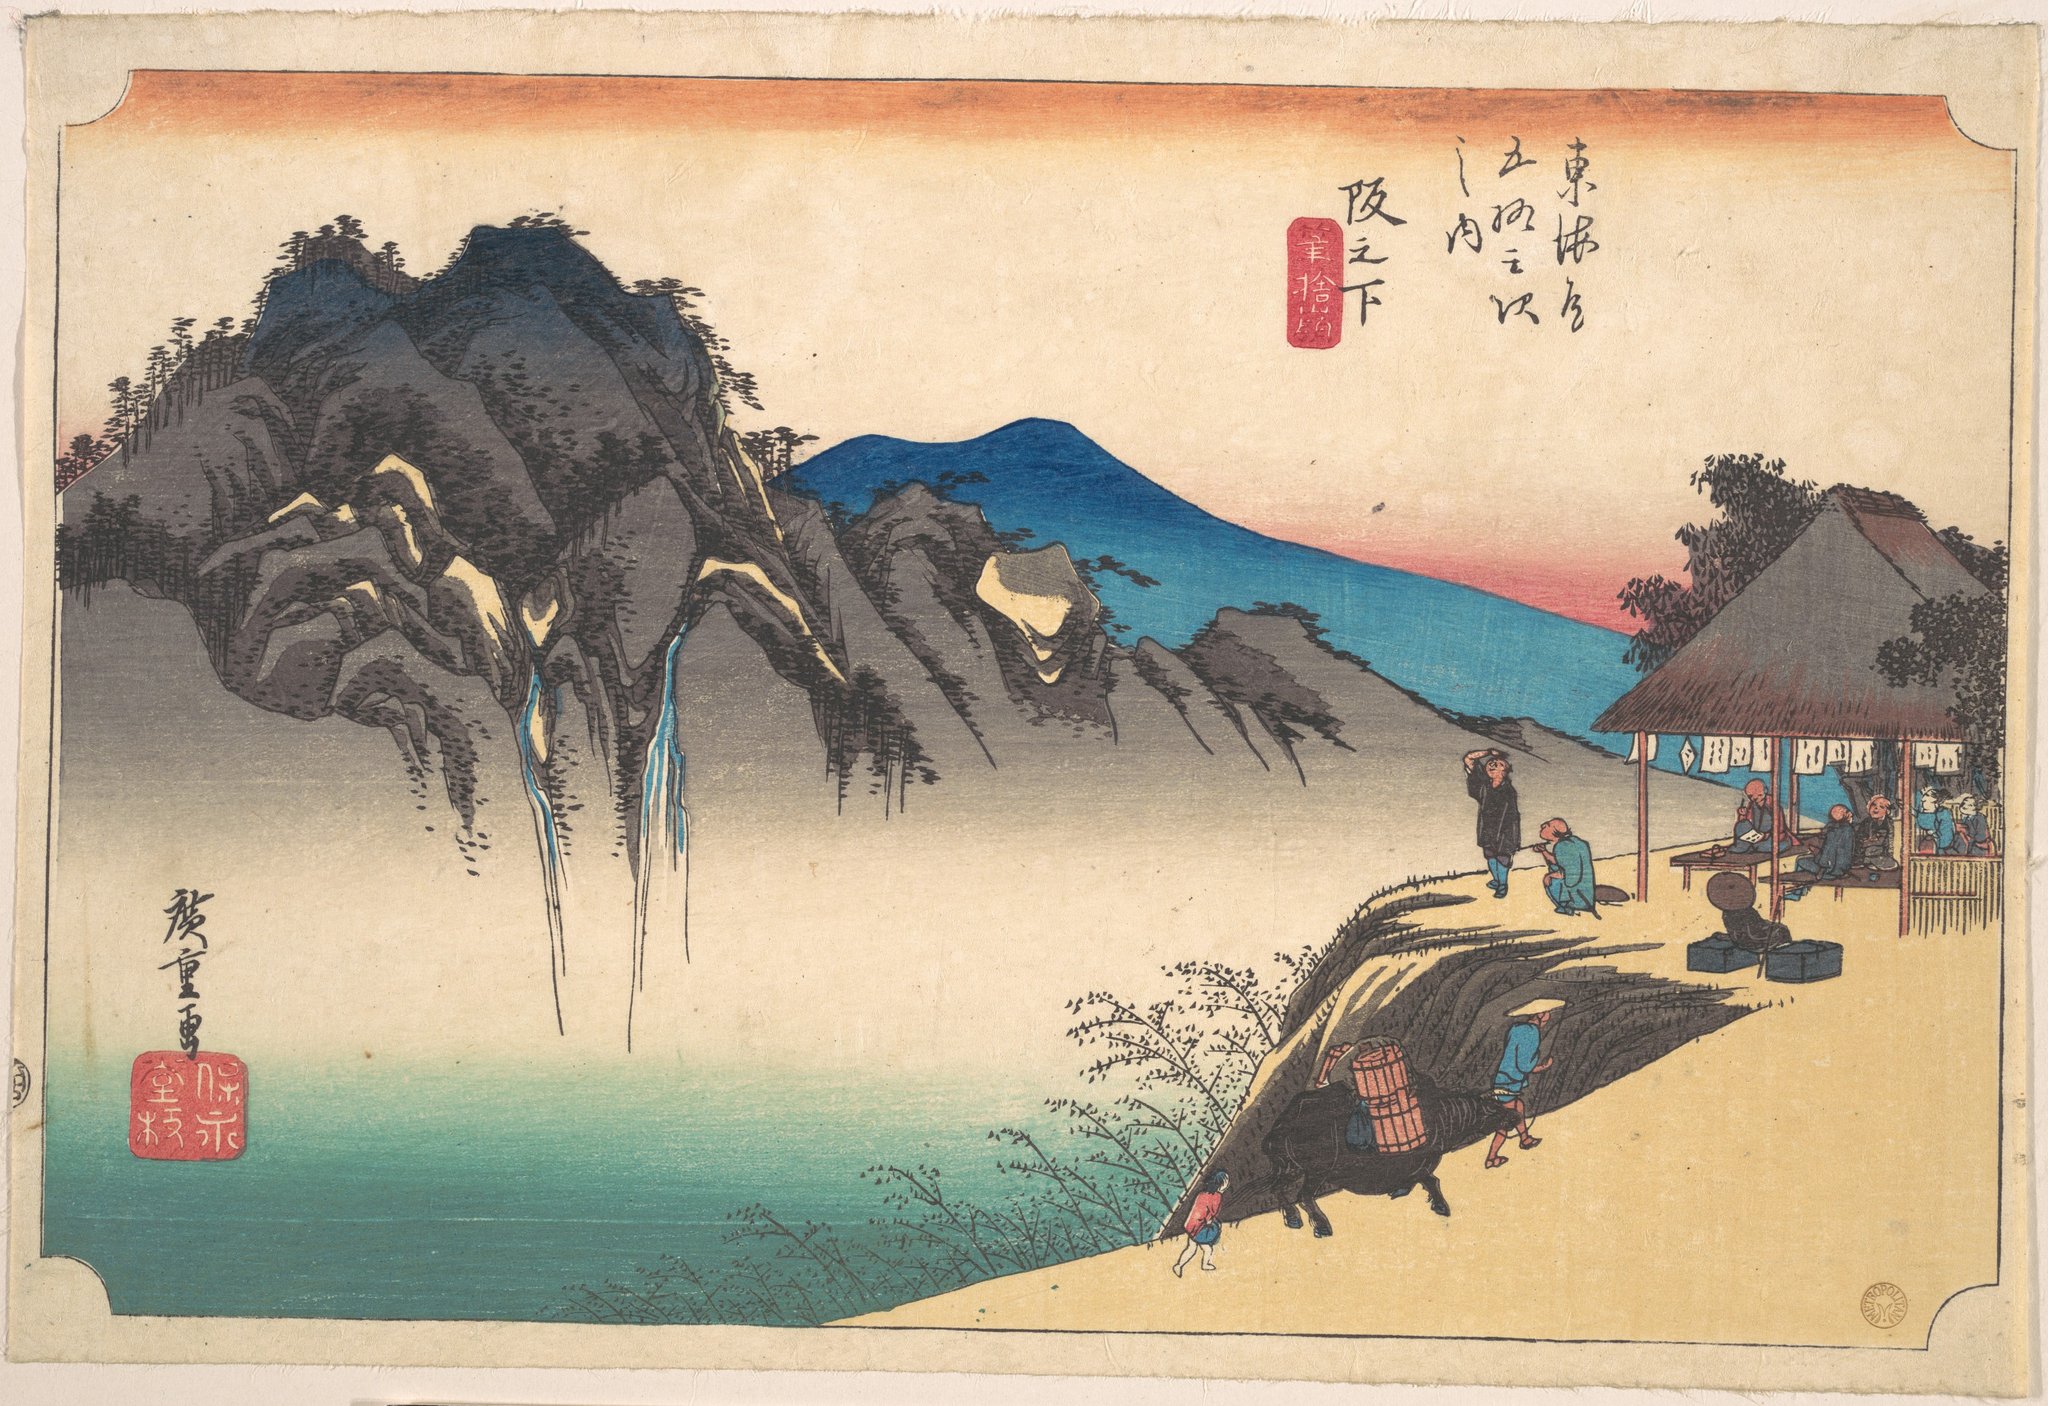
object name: print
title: Saka-no-shita, Fude-sute Mine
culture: japanese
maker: utagawa hiroshige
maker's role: artist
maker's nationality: japanese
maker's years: 1797-1858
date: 1834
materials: ink, paper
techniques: woodblock print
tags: men,mountains,landscapes